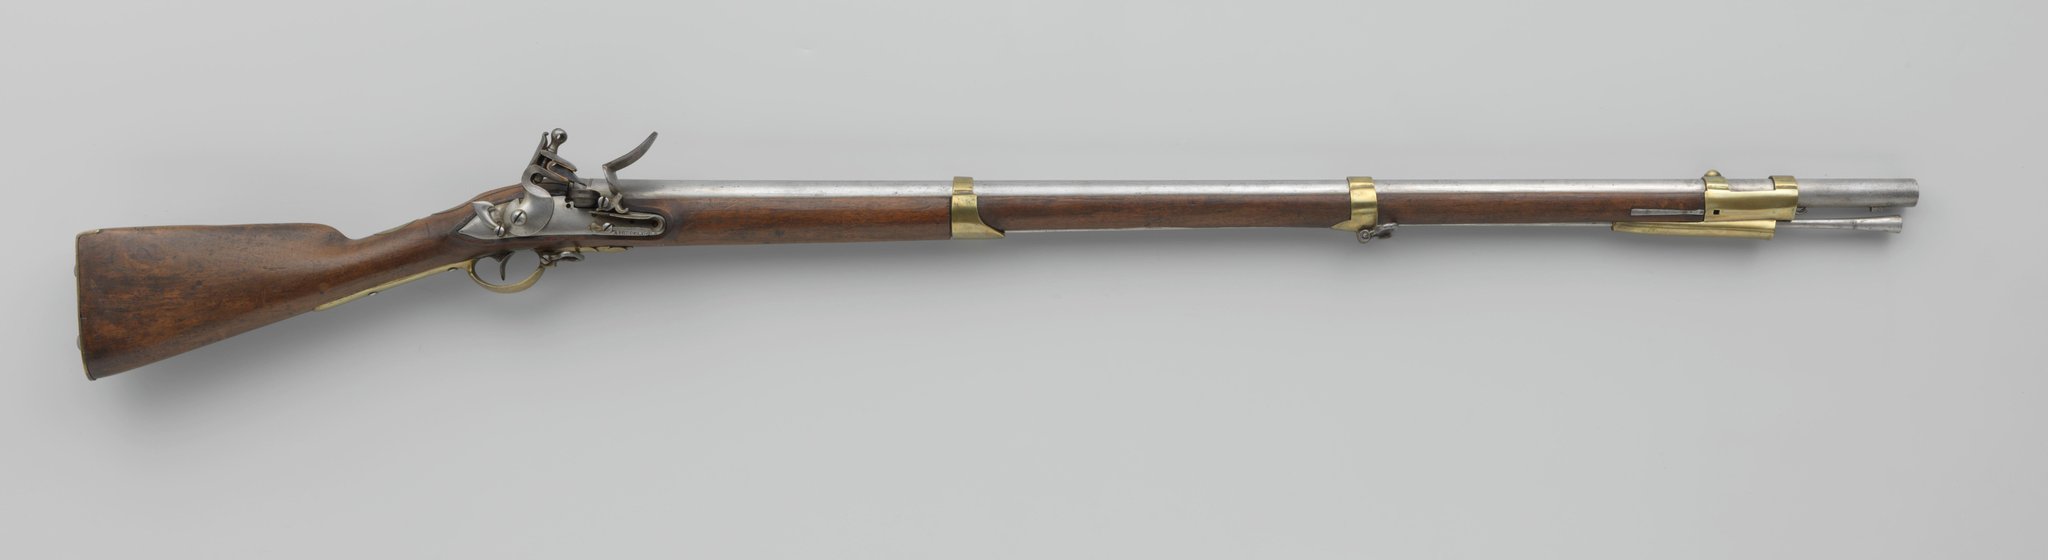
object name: flintlock pistol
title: Marine geweer gemerkt A MIDDELBURA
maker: i. rovart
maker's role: geweermaker, pistoolmaker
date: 1400-1950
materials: copper, stone, iron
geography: middelburg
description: Geweer met vuursteenslot, bajonet, ijzeren laadstok en koperen montuur. Merk van Middelburg I. Rovart, A MIDDELBURA. In gebruik geweest bij de marine.